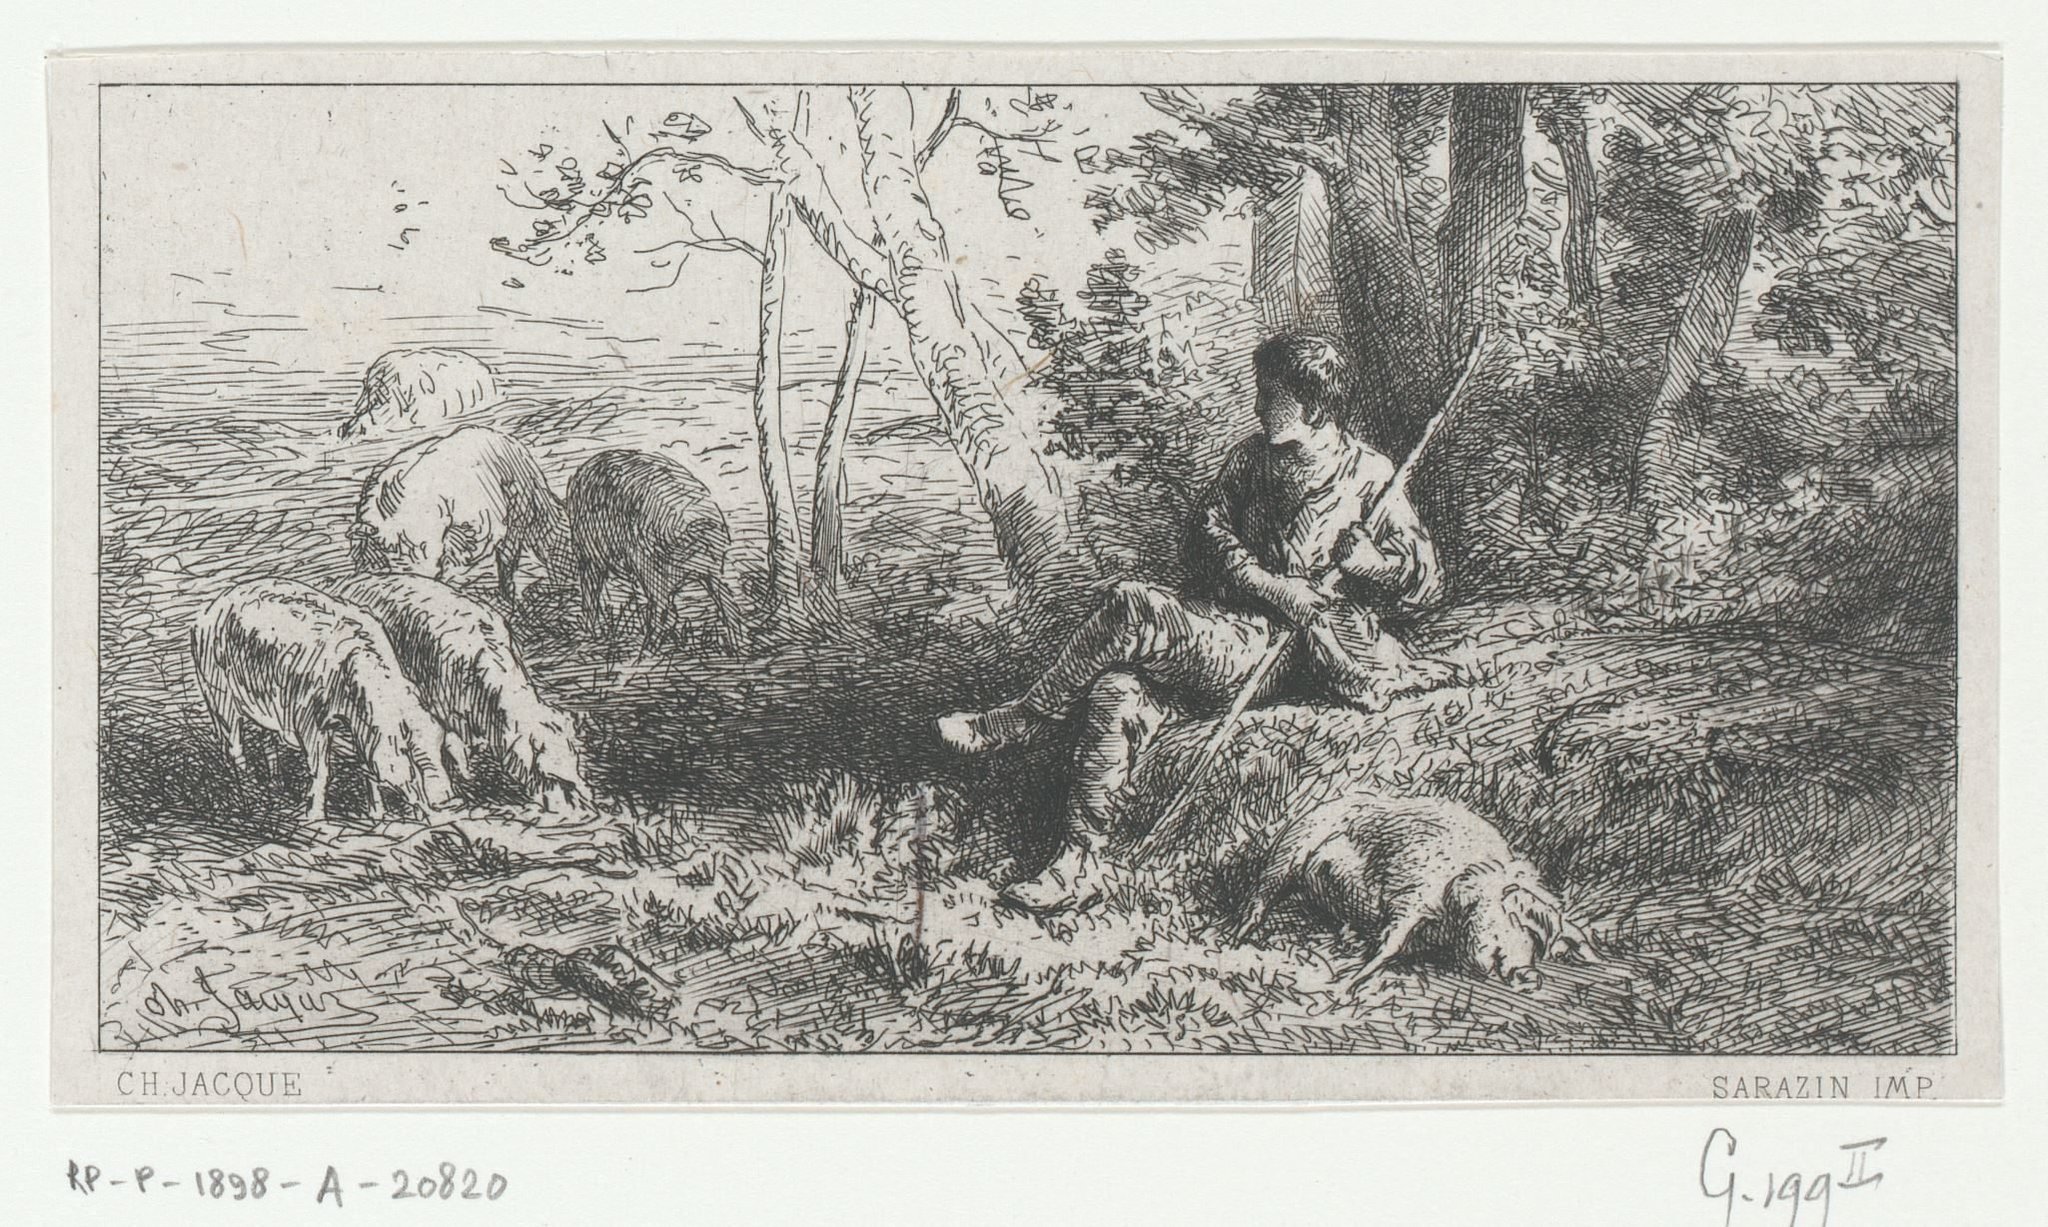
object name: print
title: Varkenshoeder met toom varkens onder een boom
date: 1864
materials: paper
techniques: drypoint, engraving, etching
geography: paris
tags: pig, herding, herdsman, herdswoman, shepherd, shepherdess, cowherd, etc.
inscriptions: collector's mark: Lugt 964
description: Maakt deel uit van een serie zonder titel met 25 prenten met verschillende landelijke en pastorale motieven door Jacque. De serie werd uitgegeven in 1864.